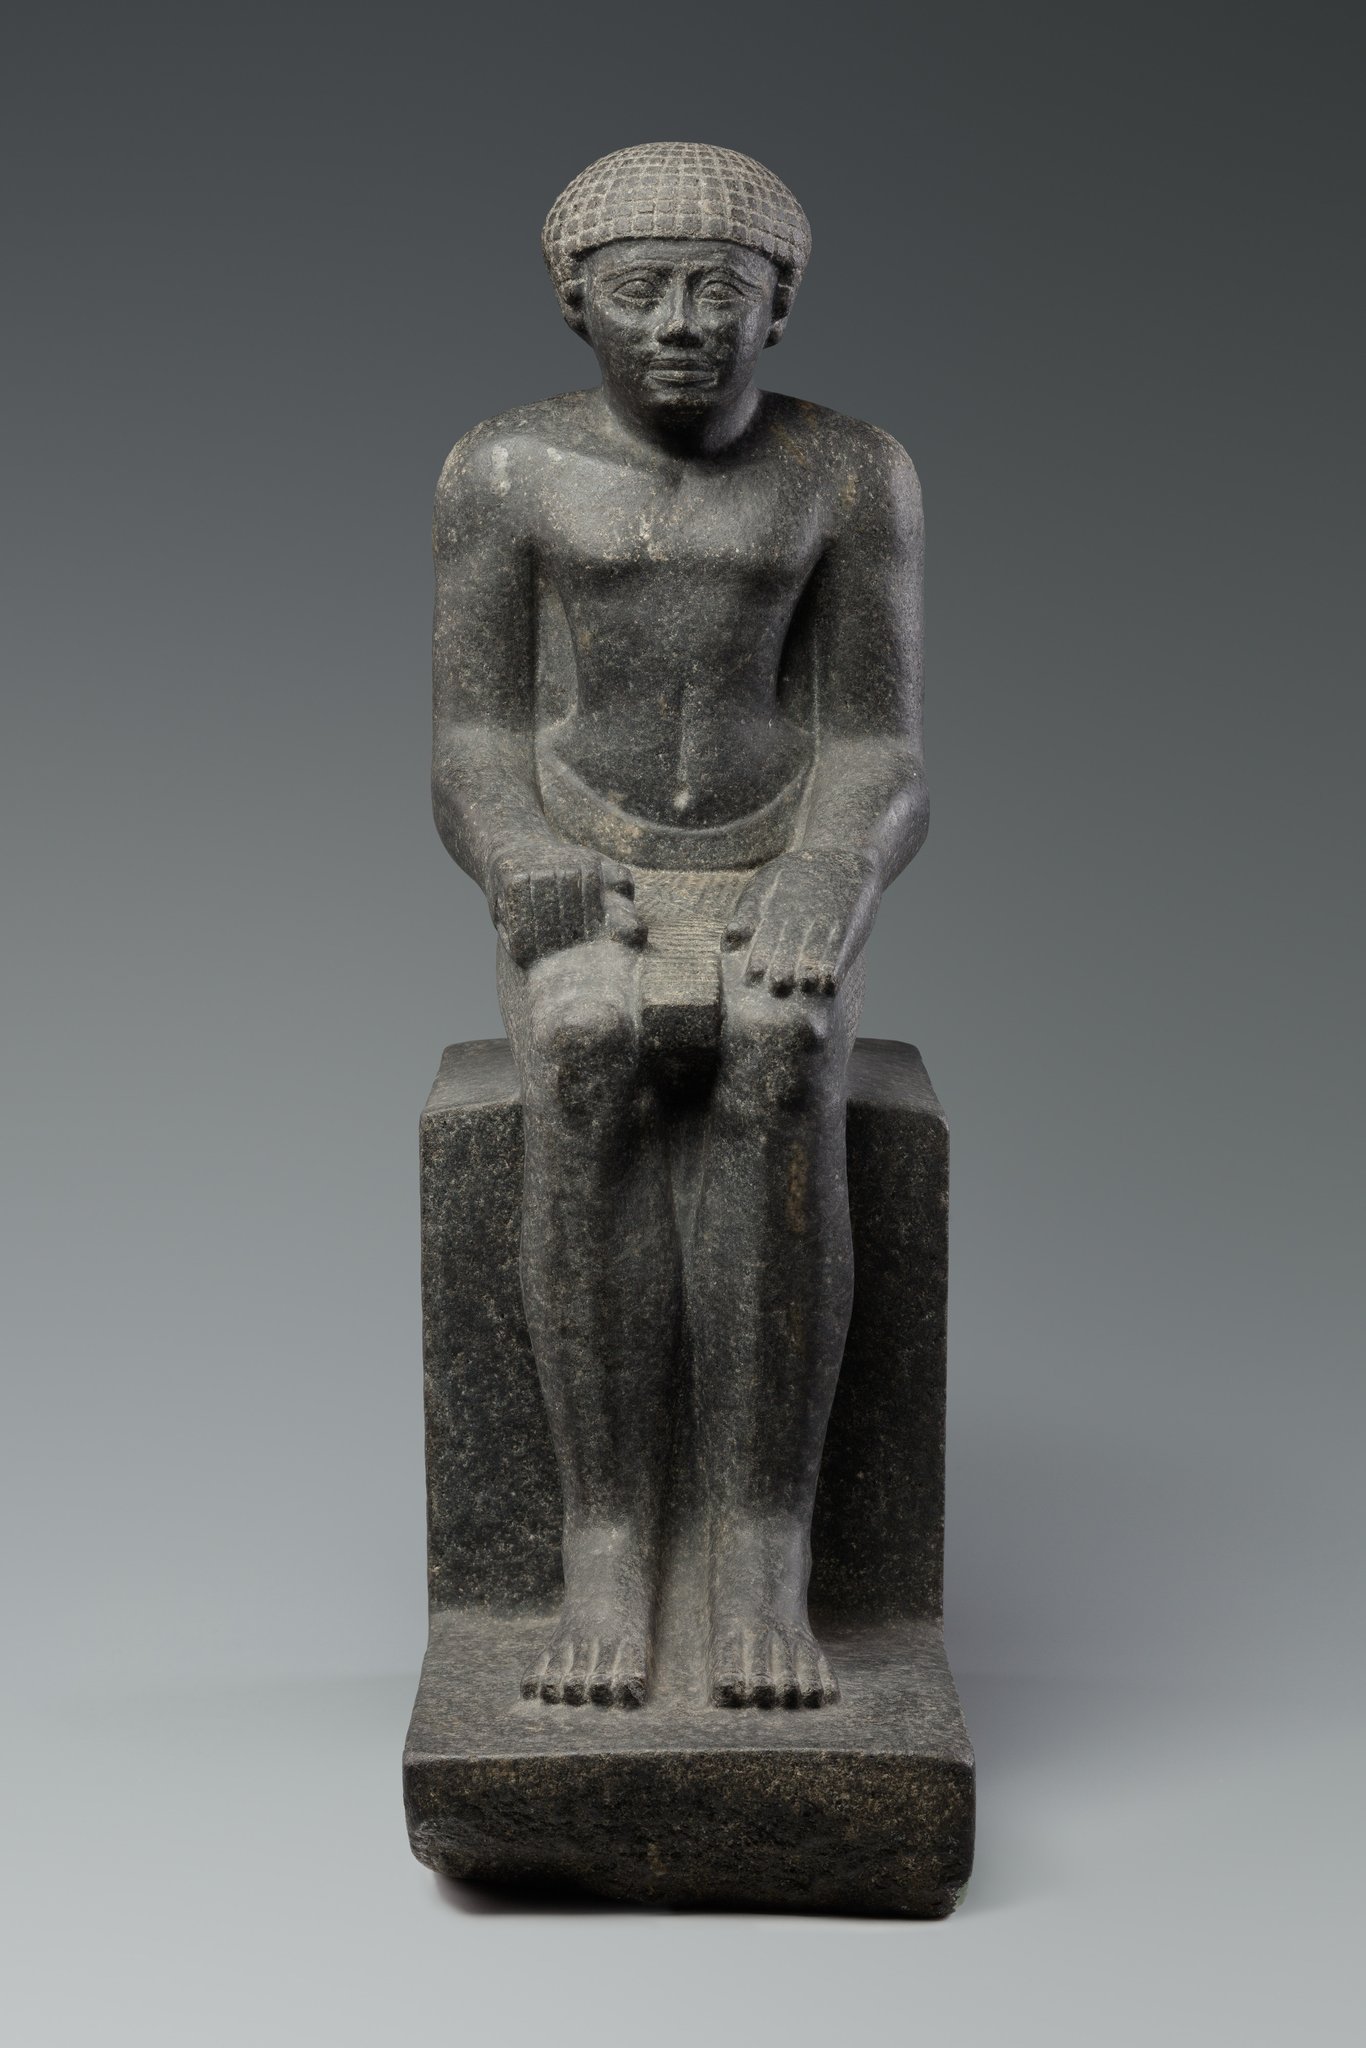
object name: statue, seated mentuhotep with short wig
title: The Chief of Police, Mentuhotep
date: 1981-1917 BCE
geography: egypt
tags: men,hieroglyphs,police